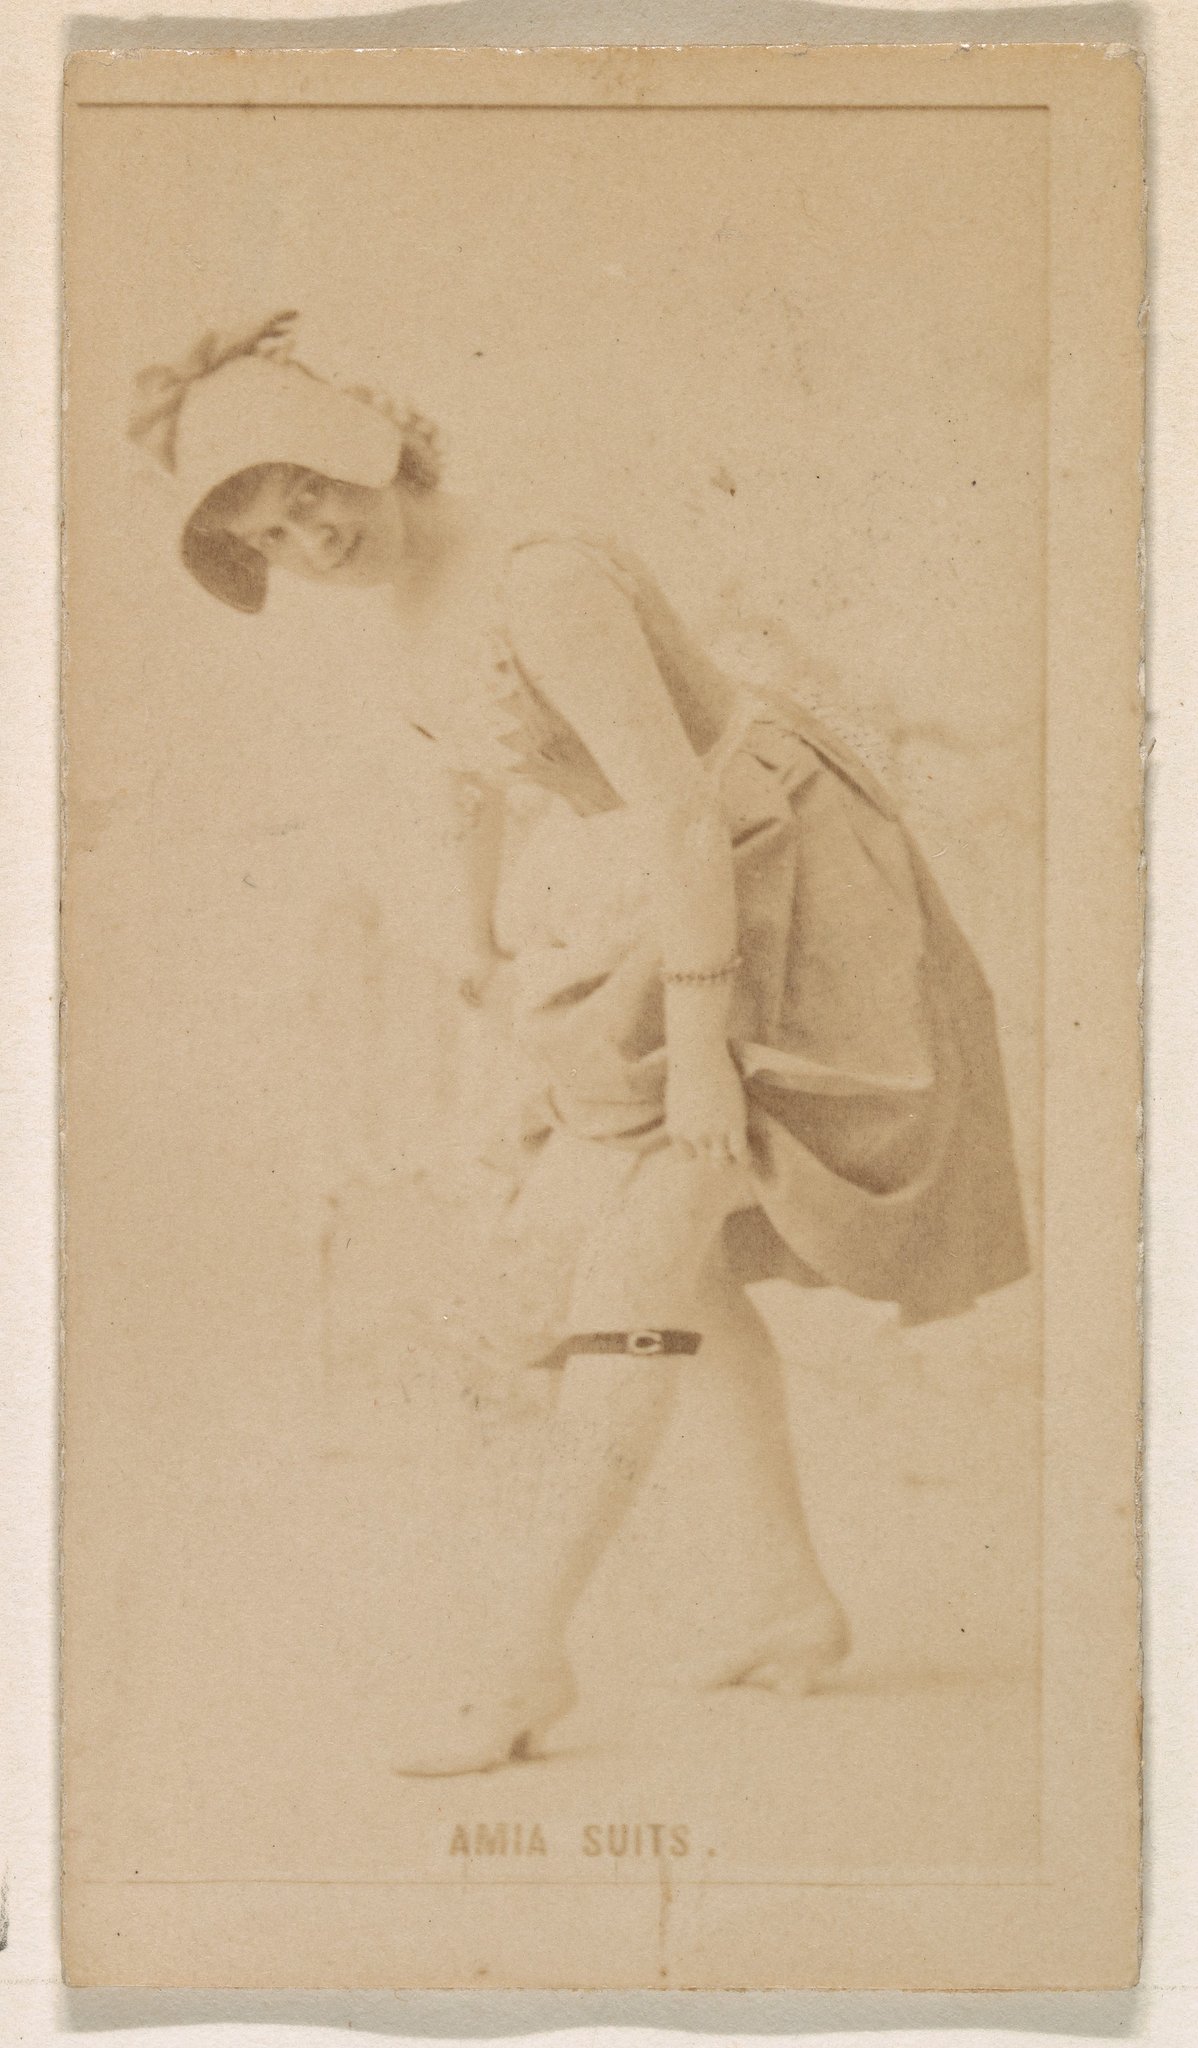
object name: photograph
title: Anna Suits, from the Actresses series (N245) issued by Kinney Brothers to promote Sweet Caporal Cigarettes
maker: kinney brothers tobacco company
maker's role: publisher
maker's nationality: american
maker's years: 1869-2011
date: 1890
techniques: albumen silver print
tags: portraits,women,actresses